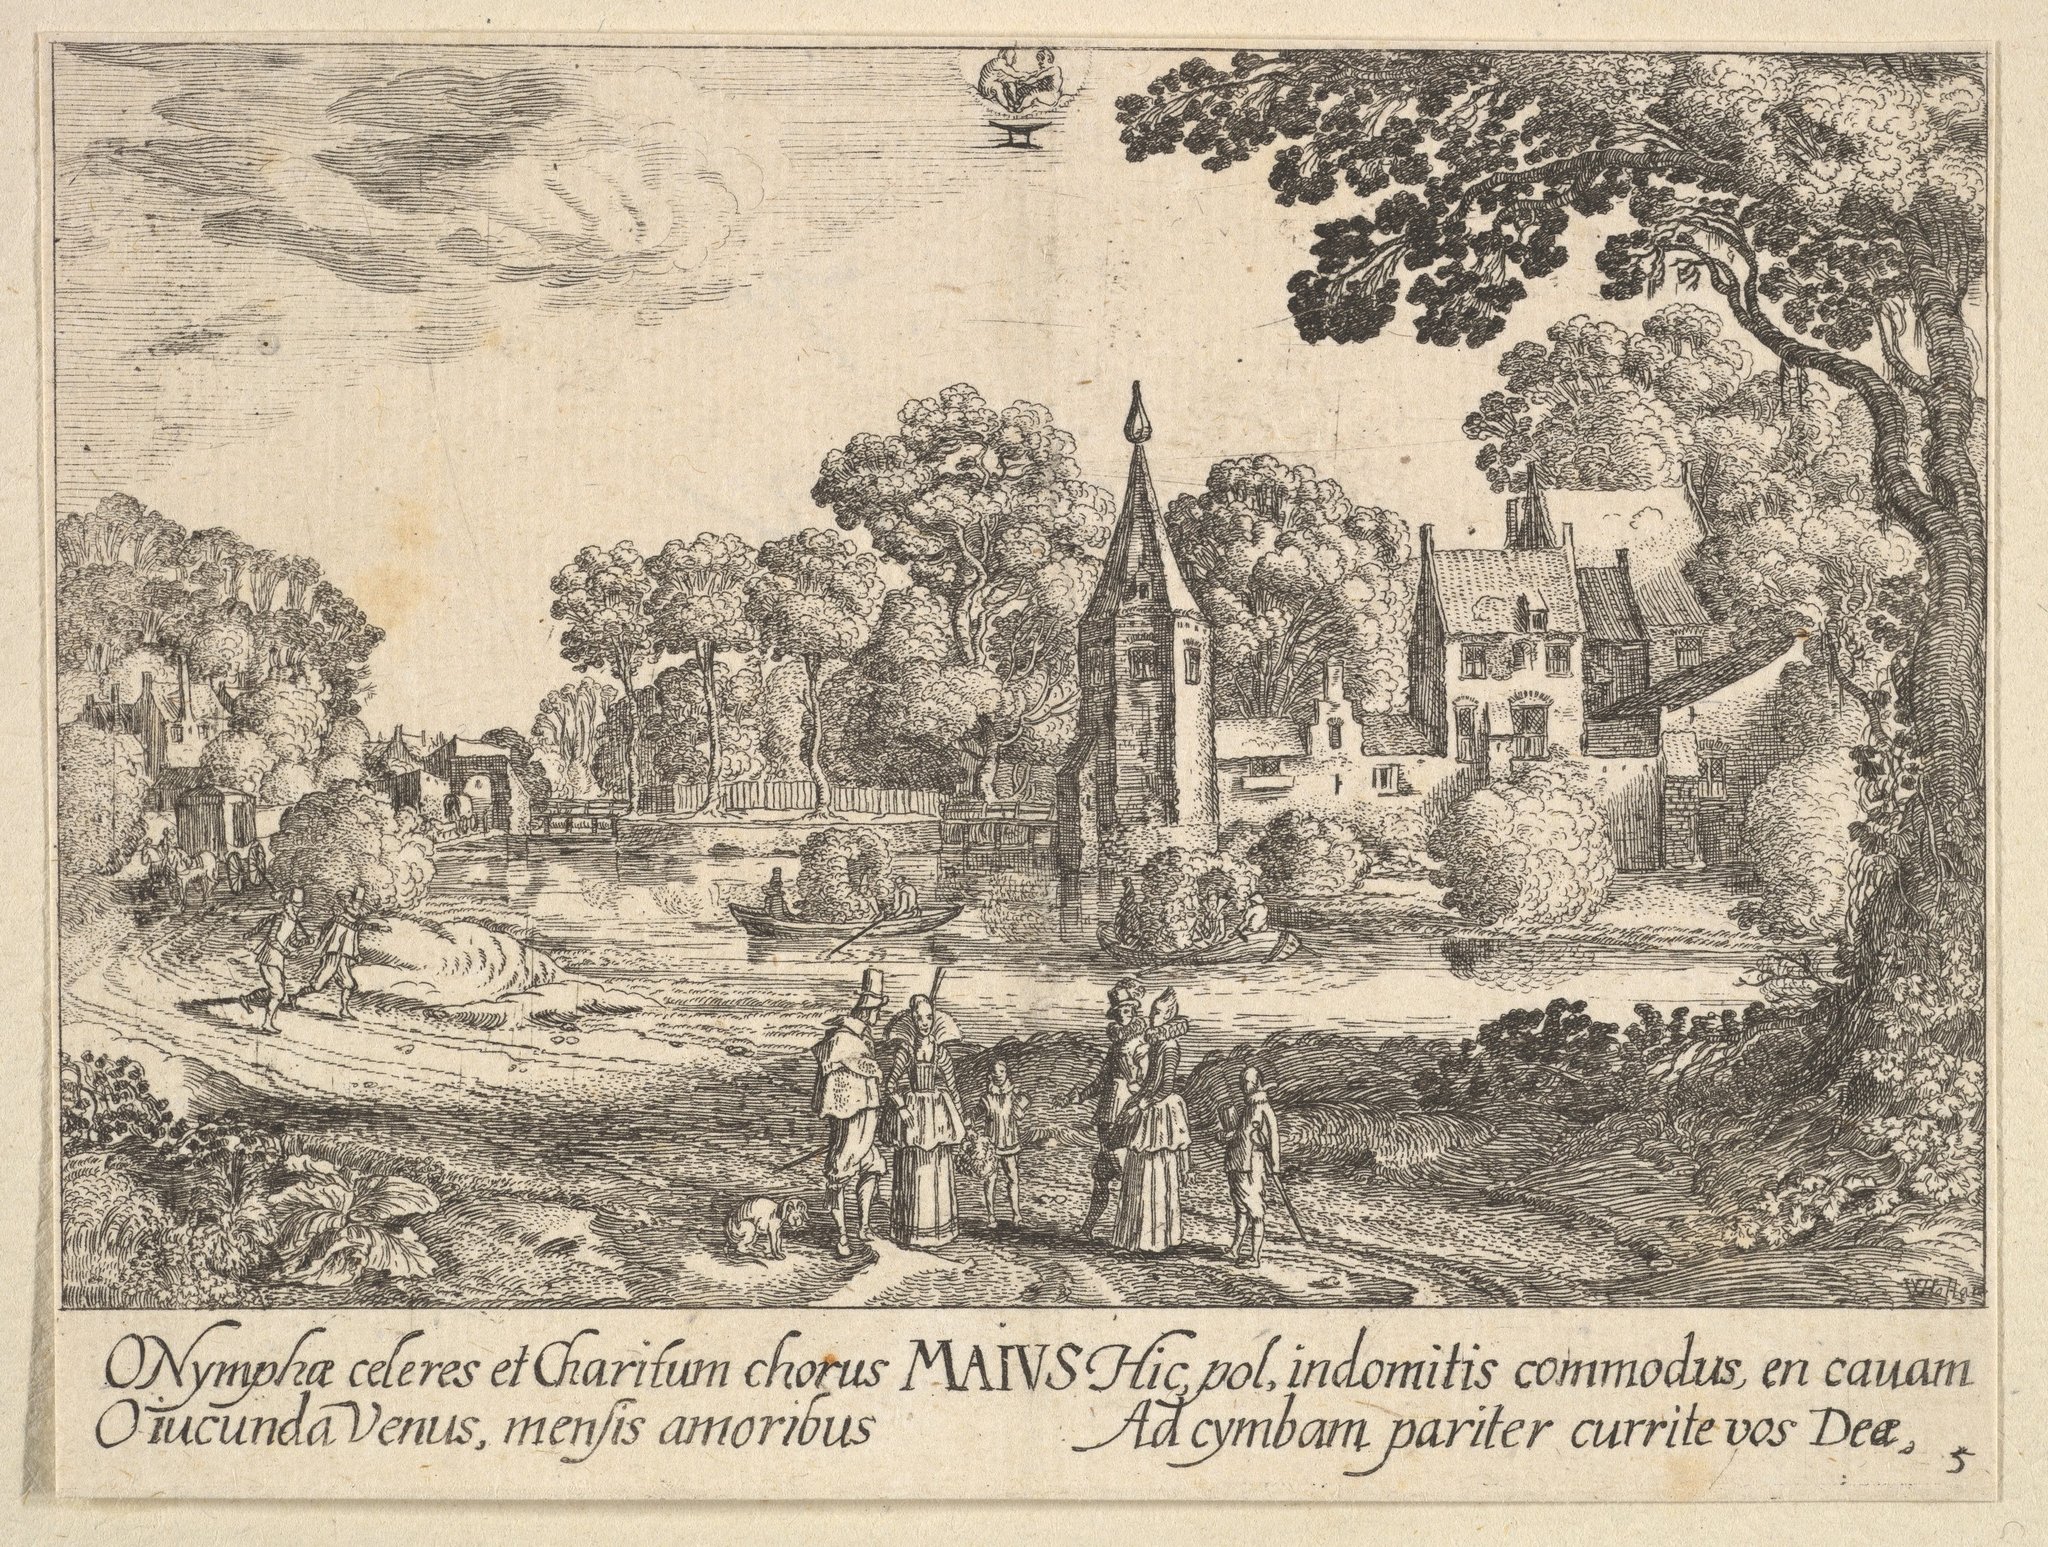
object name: print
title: May (Maius)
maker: wenceslaus hollar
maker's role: artist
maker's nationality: bohemian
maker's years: 1607-1677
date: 1628-1629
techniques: etching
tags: men,women,dogs,genre scene